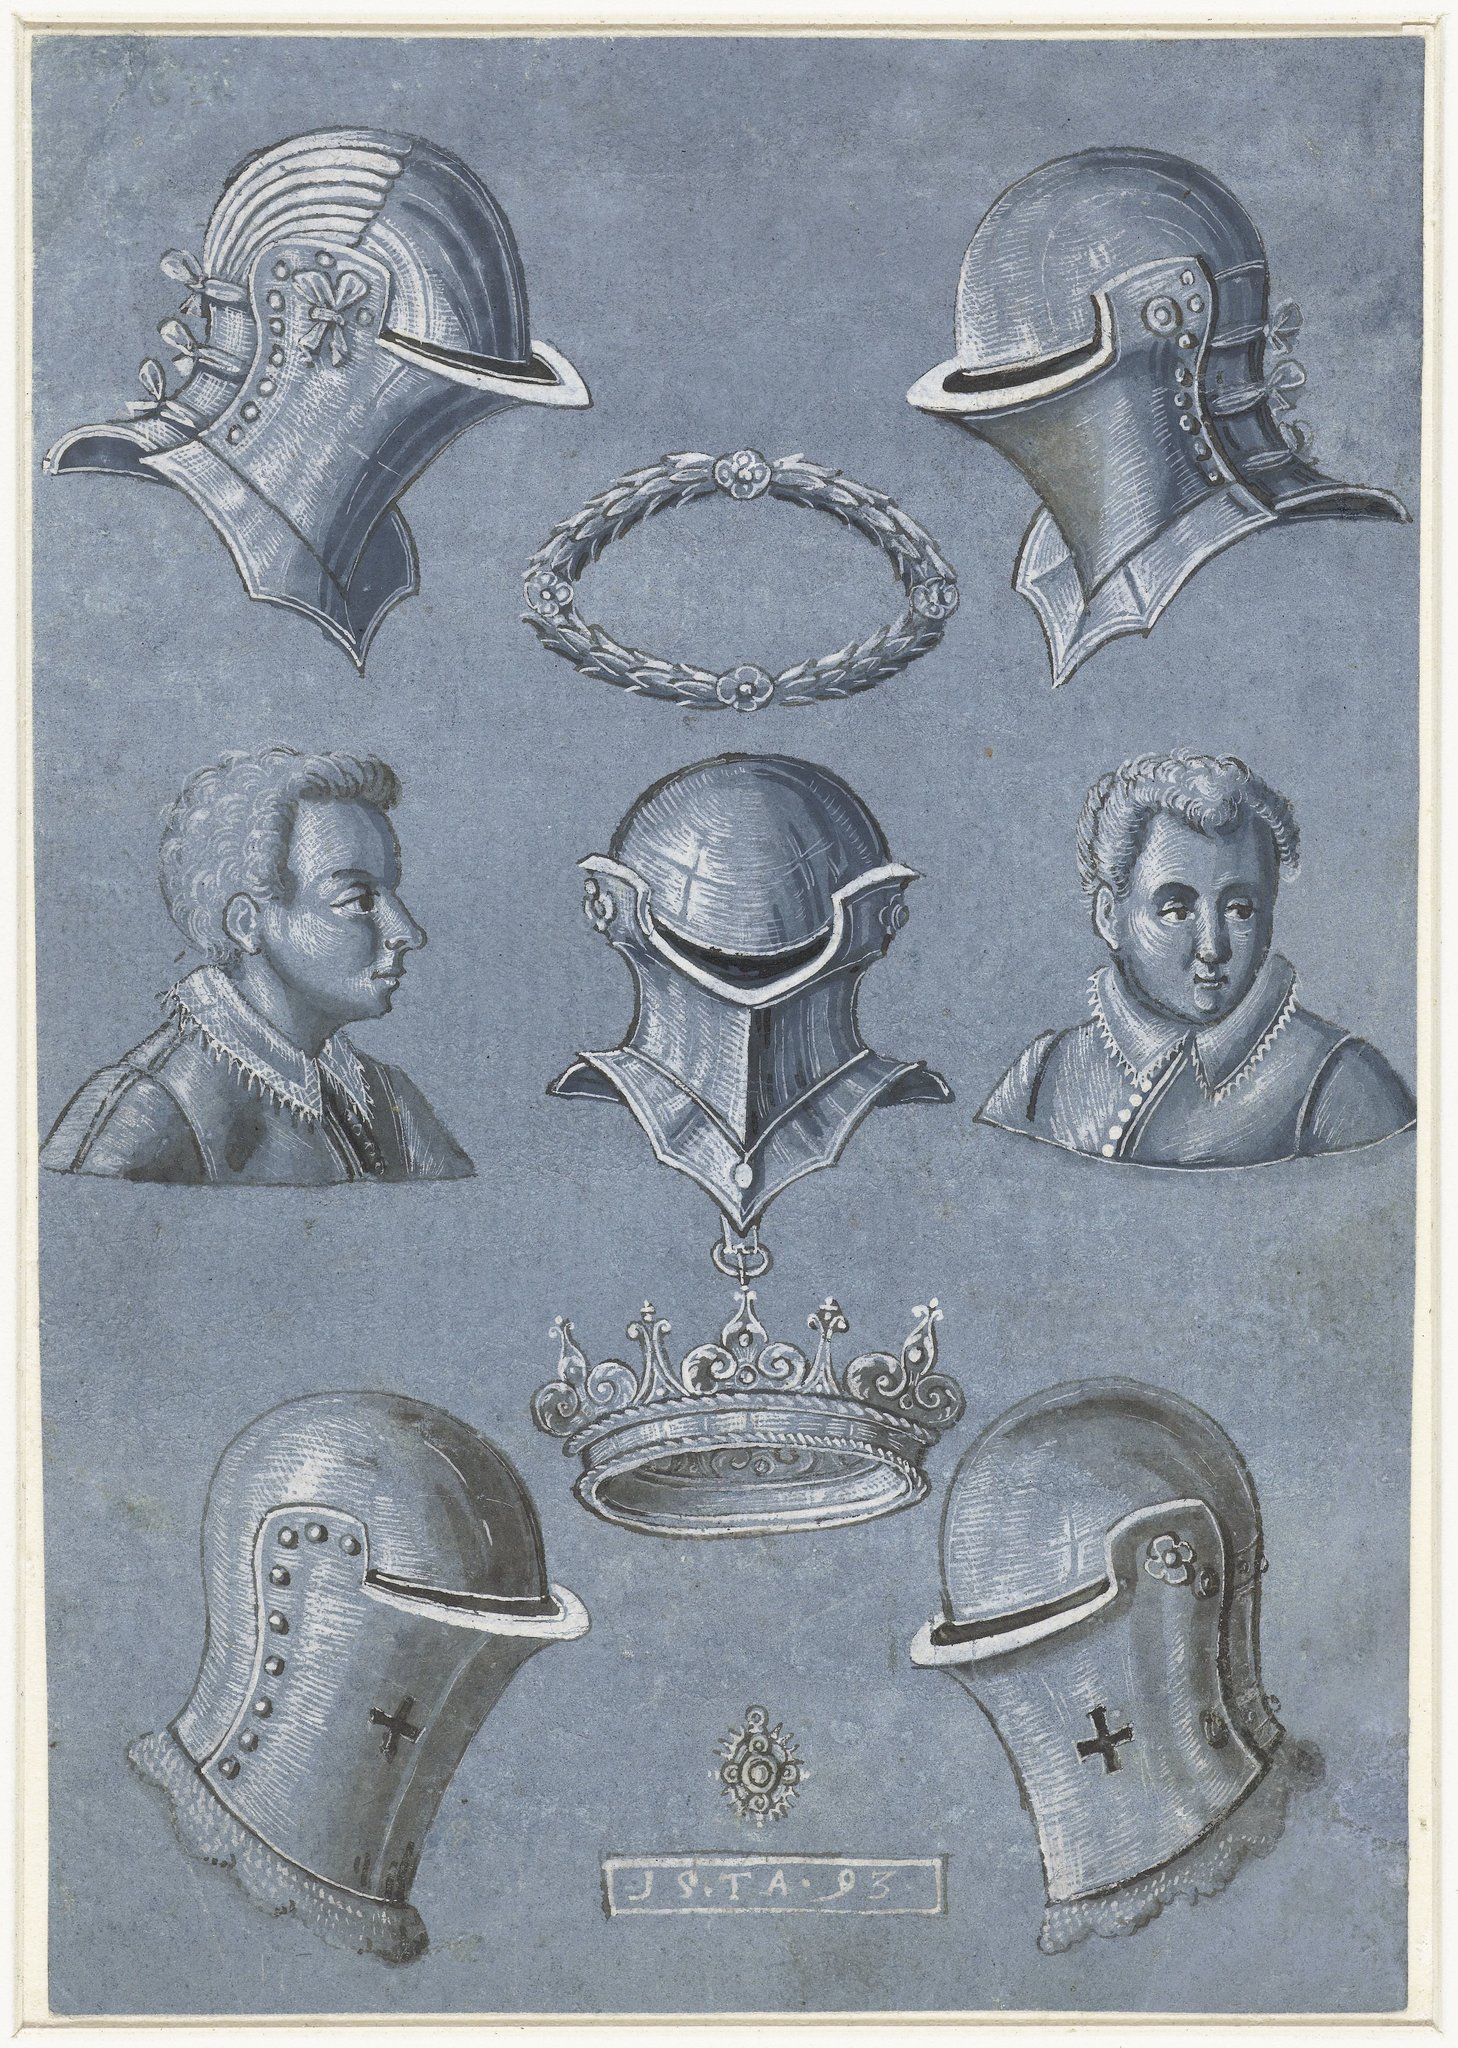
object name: drawing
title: Blad met vijf helmen, een kroon, een lauwerkrans en twee bustes van jongelingen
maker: monogrammist ta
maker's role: draughtsman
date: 1593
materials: paint, paper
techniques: brush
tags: helmet, crown (symbol of sovereignty)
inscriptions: date: ‘1593’